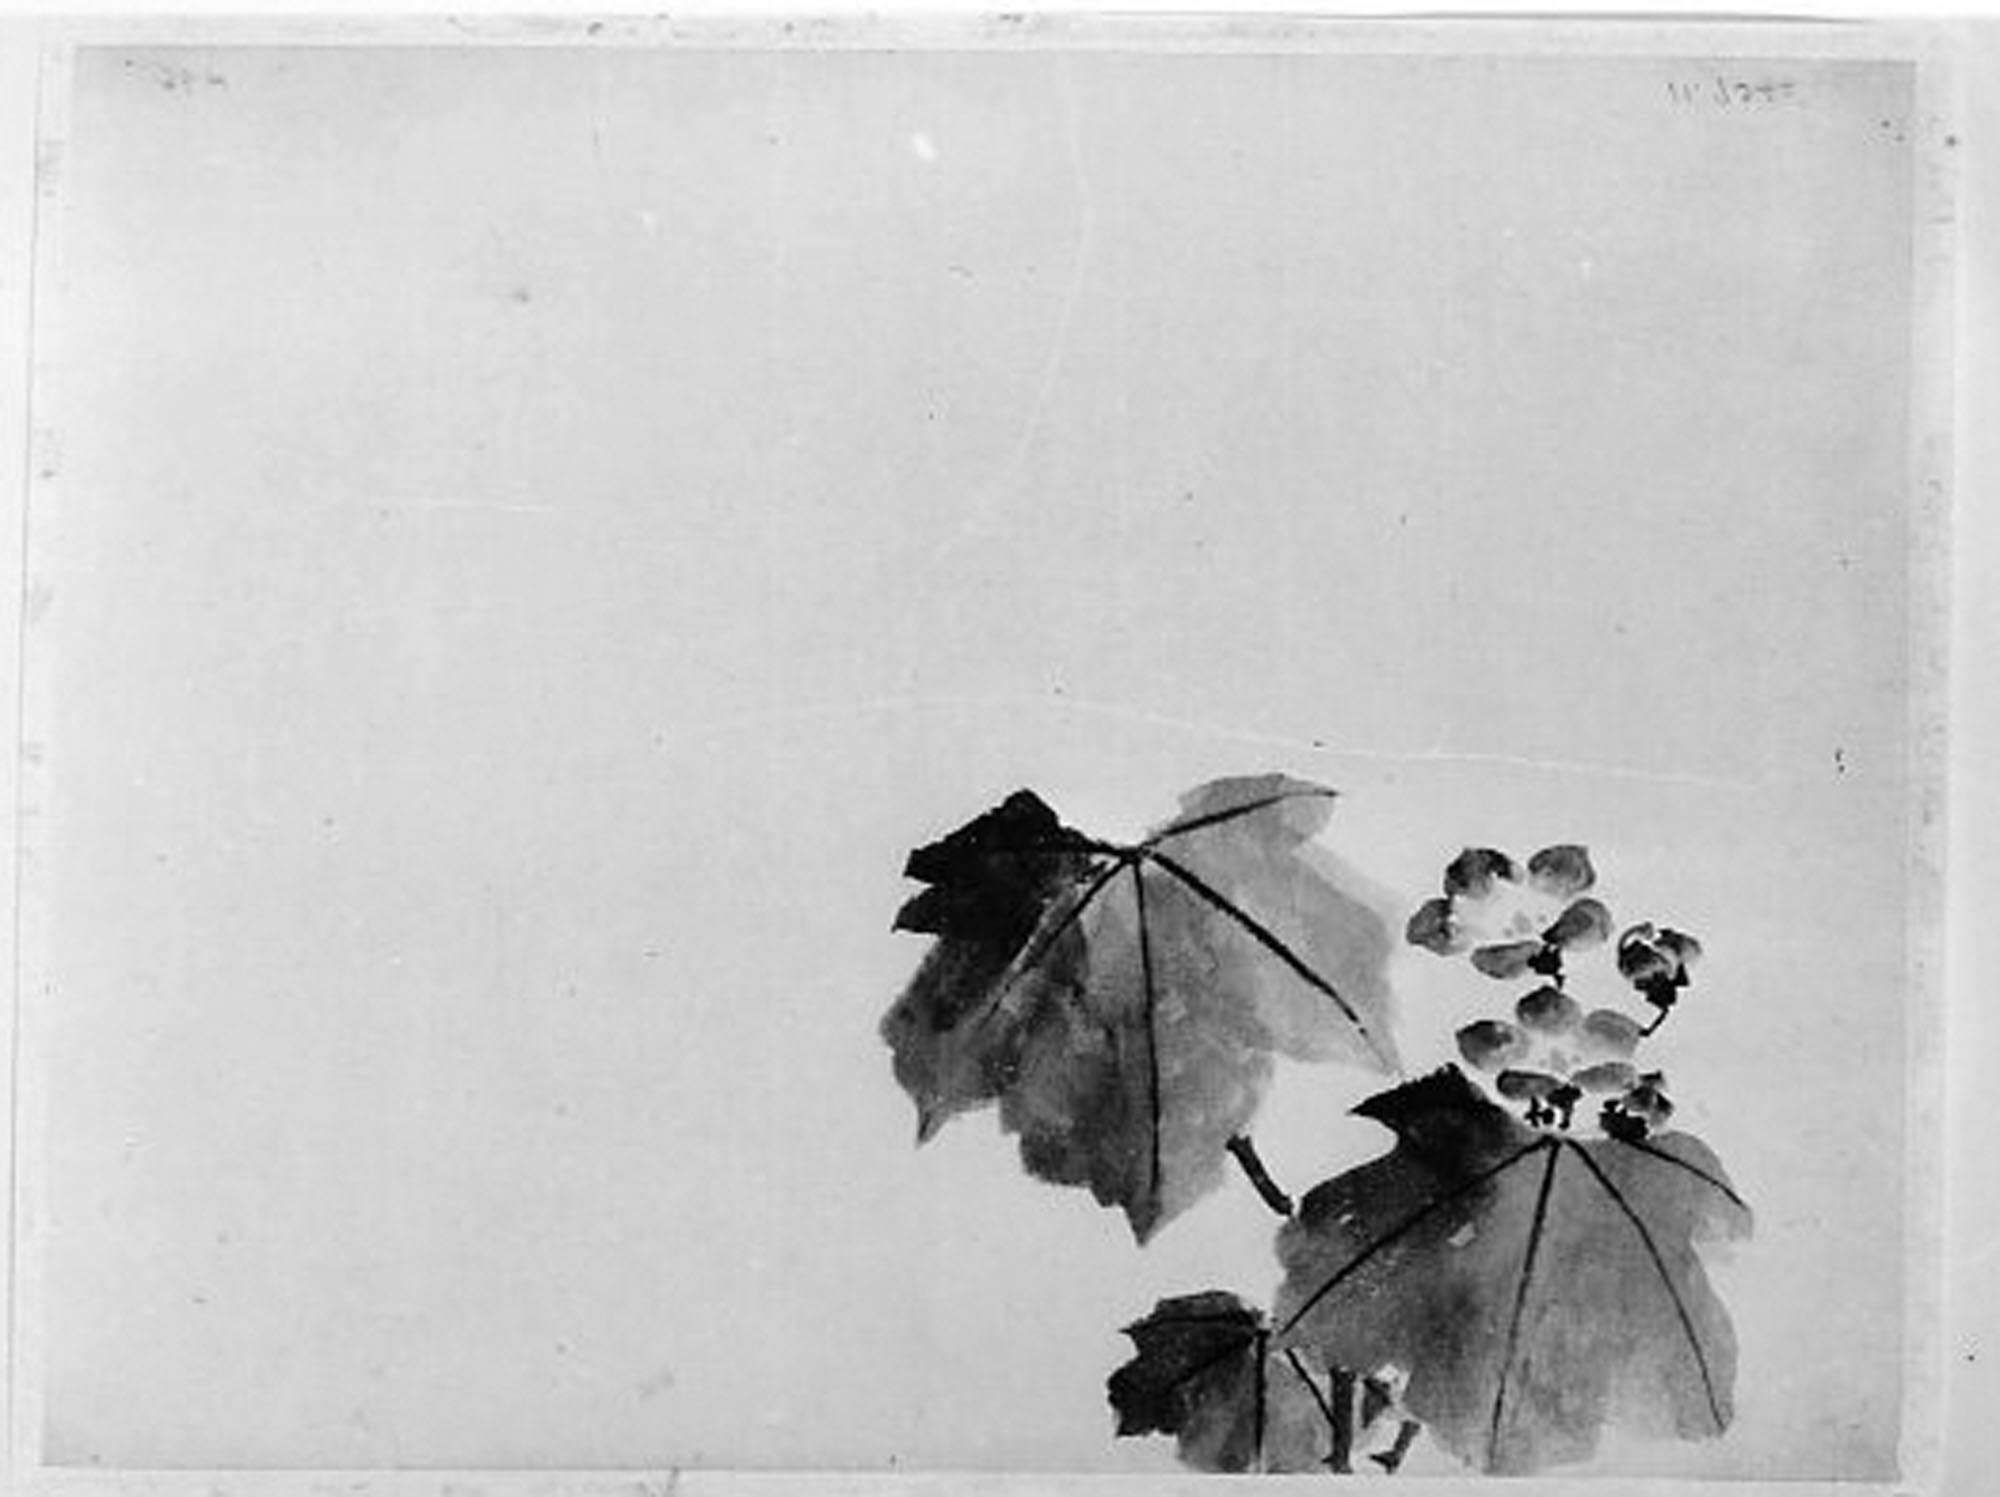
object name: painting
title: Bellflower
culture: japanese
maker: hokusai school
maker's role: artist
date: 1801-1900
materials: ink, paper, watercolor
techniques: painting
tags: leaves